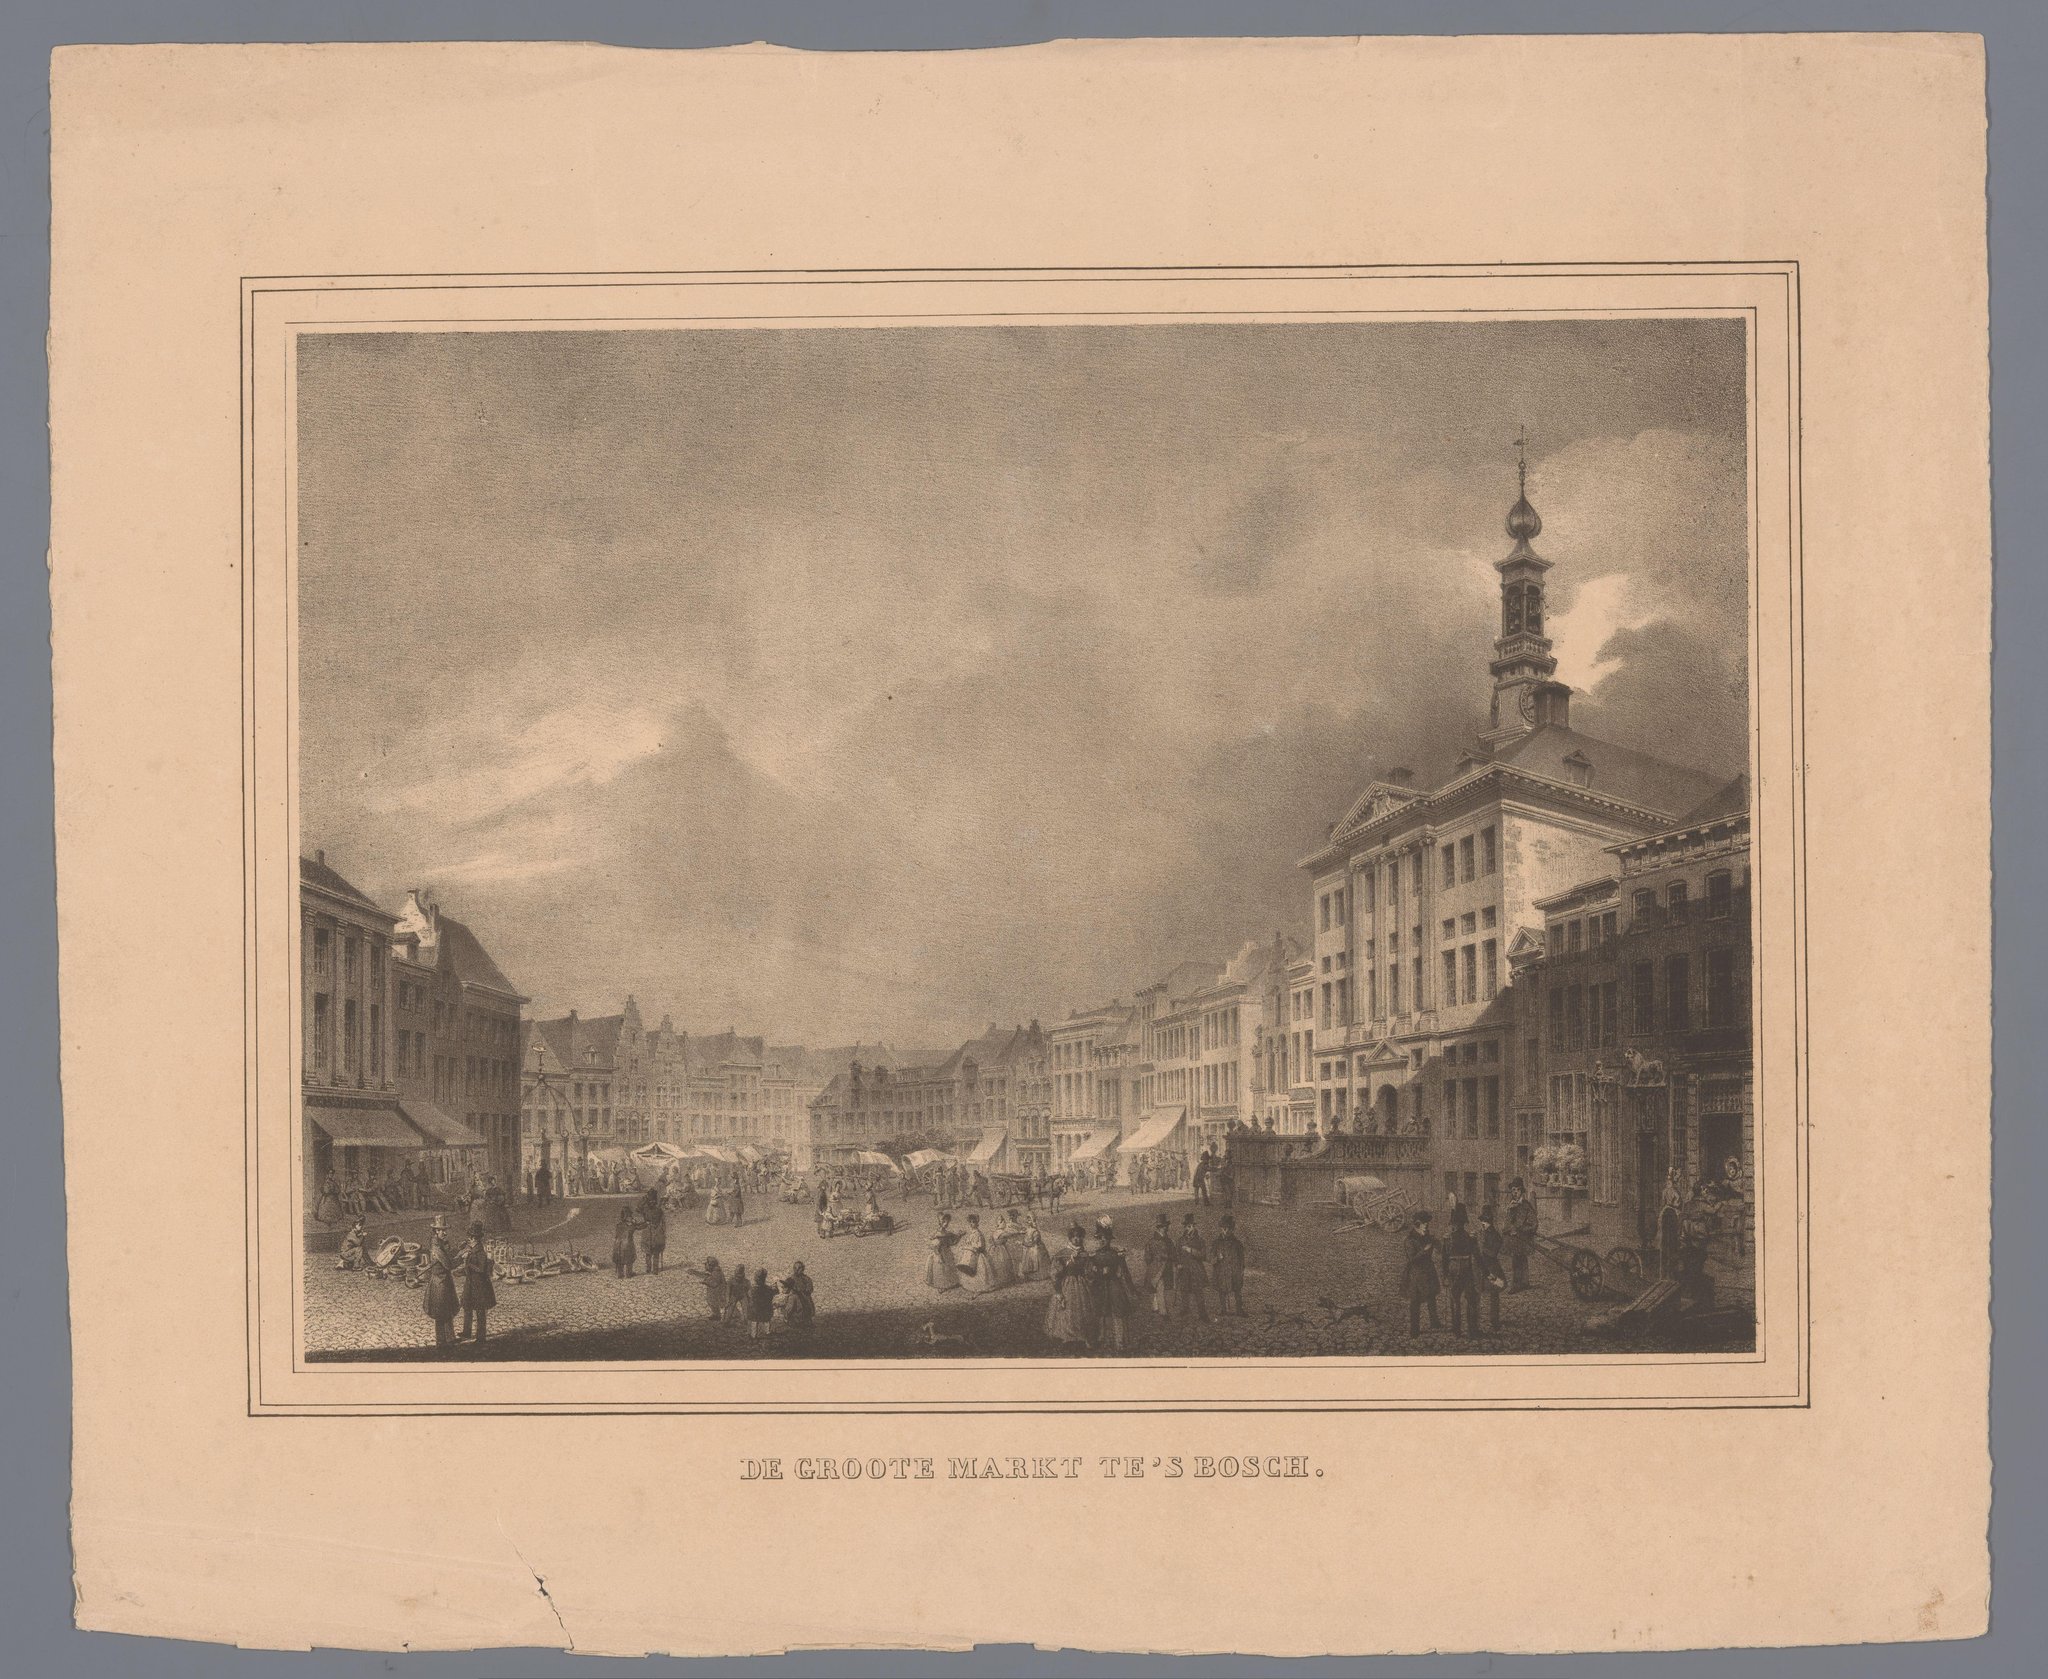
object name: print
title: Gezicht op de Grote Markt van 's-Hertogenbosch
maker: Anonymous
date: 1830-1880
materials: paper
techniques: lithograph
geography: netherlands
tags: townhall, square, place, circus, etc. (+ city(-scape) with figures, staffage)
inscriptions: collector's mark: Lugt 2228